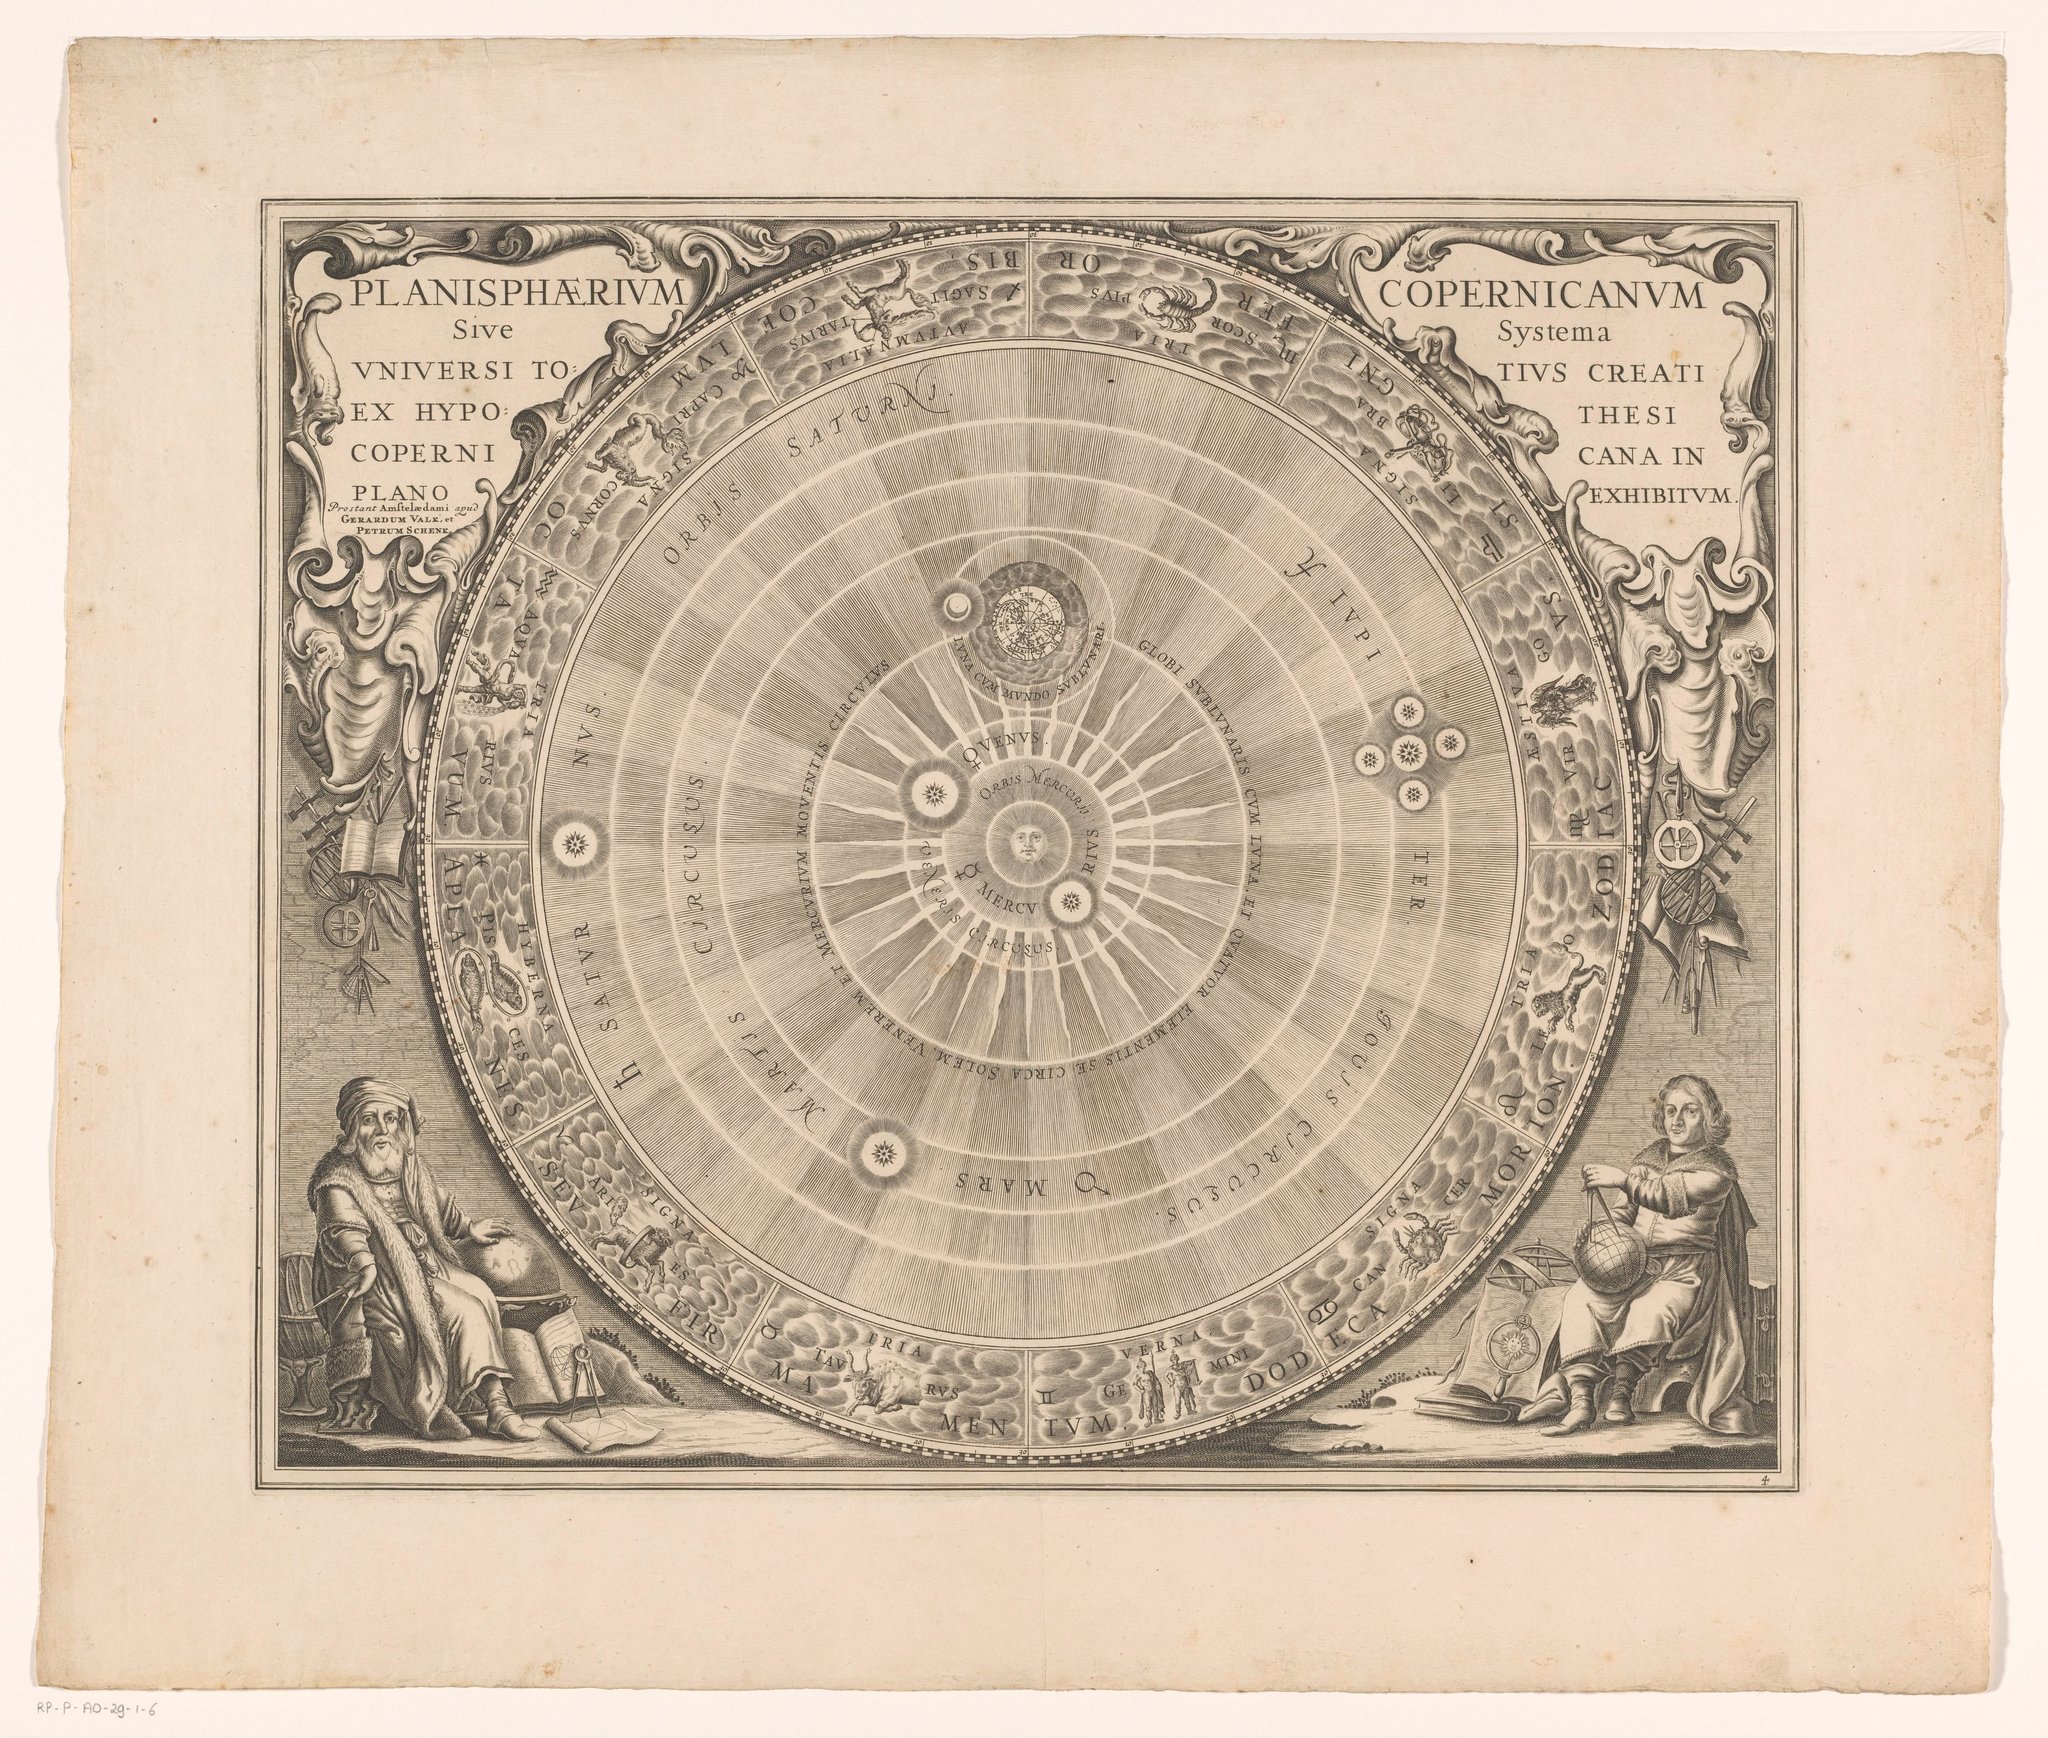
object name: map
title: Planisphaerium Copernicanum sive systema universi totius creati ex hypothesi (...)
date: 1660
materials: paper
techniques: engraving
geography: amsterdam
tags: zodiac; the twelve zodiacal signs together, star-chart, star map, planets; planetary system, solar system, instruments used in geodesy, surveying instruments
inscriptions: collector's mark: Lugt 2228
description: Hemelkaart waar het heliocentrische stelsel van Nicolaas Copernicus op te zien is. In het midden de zon, met daaromheen de banen van de planeten en de aarde om de zon. Om Jupiter heen zijn vier manen te zien, die in 1610 door Galileo Galilei ontdekt zijn. In de buitenste ring de dierenriem. De kaart is voorzien van een gradenverdeling langs de randen. Links- en rechtsboven de titelcartouches. Links- en rechtsonder een voorstelling met zittende cartograaf, die waarschijnlijk Nicolaas Copernicus en Aristarchus van Samos voorstellen. Rechtsonder genummerd: 4.